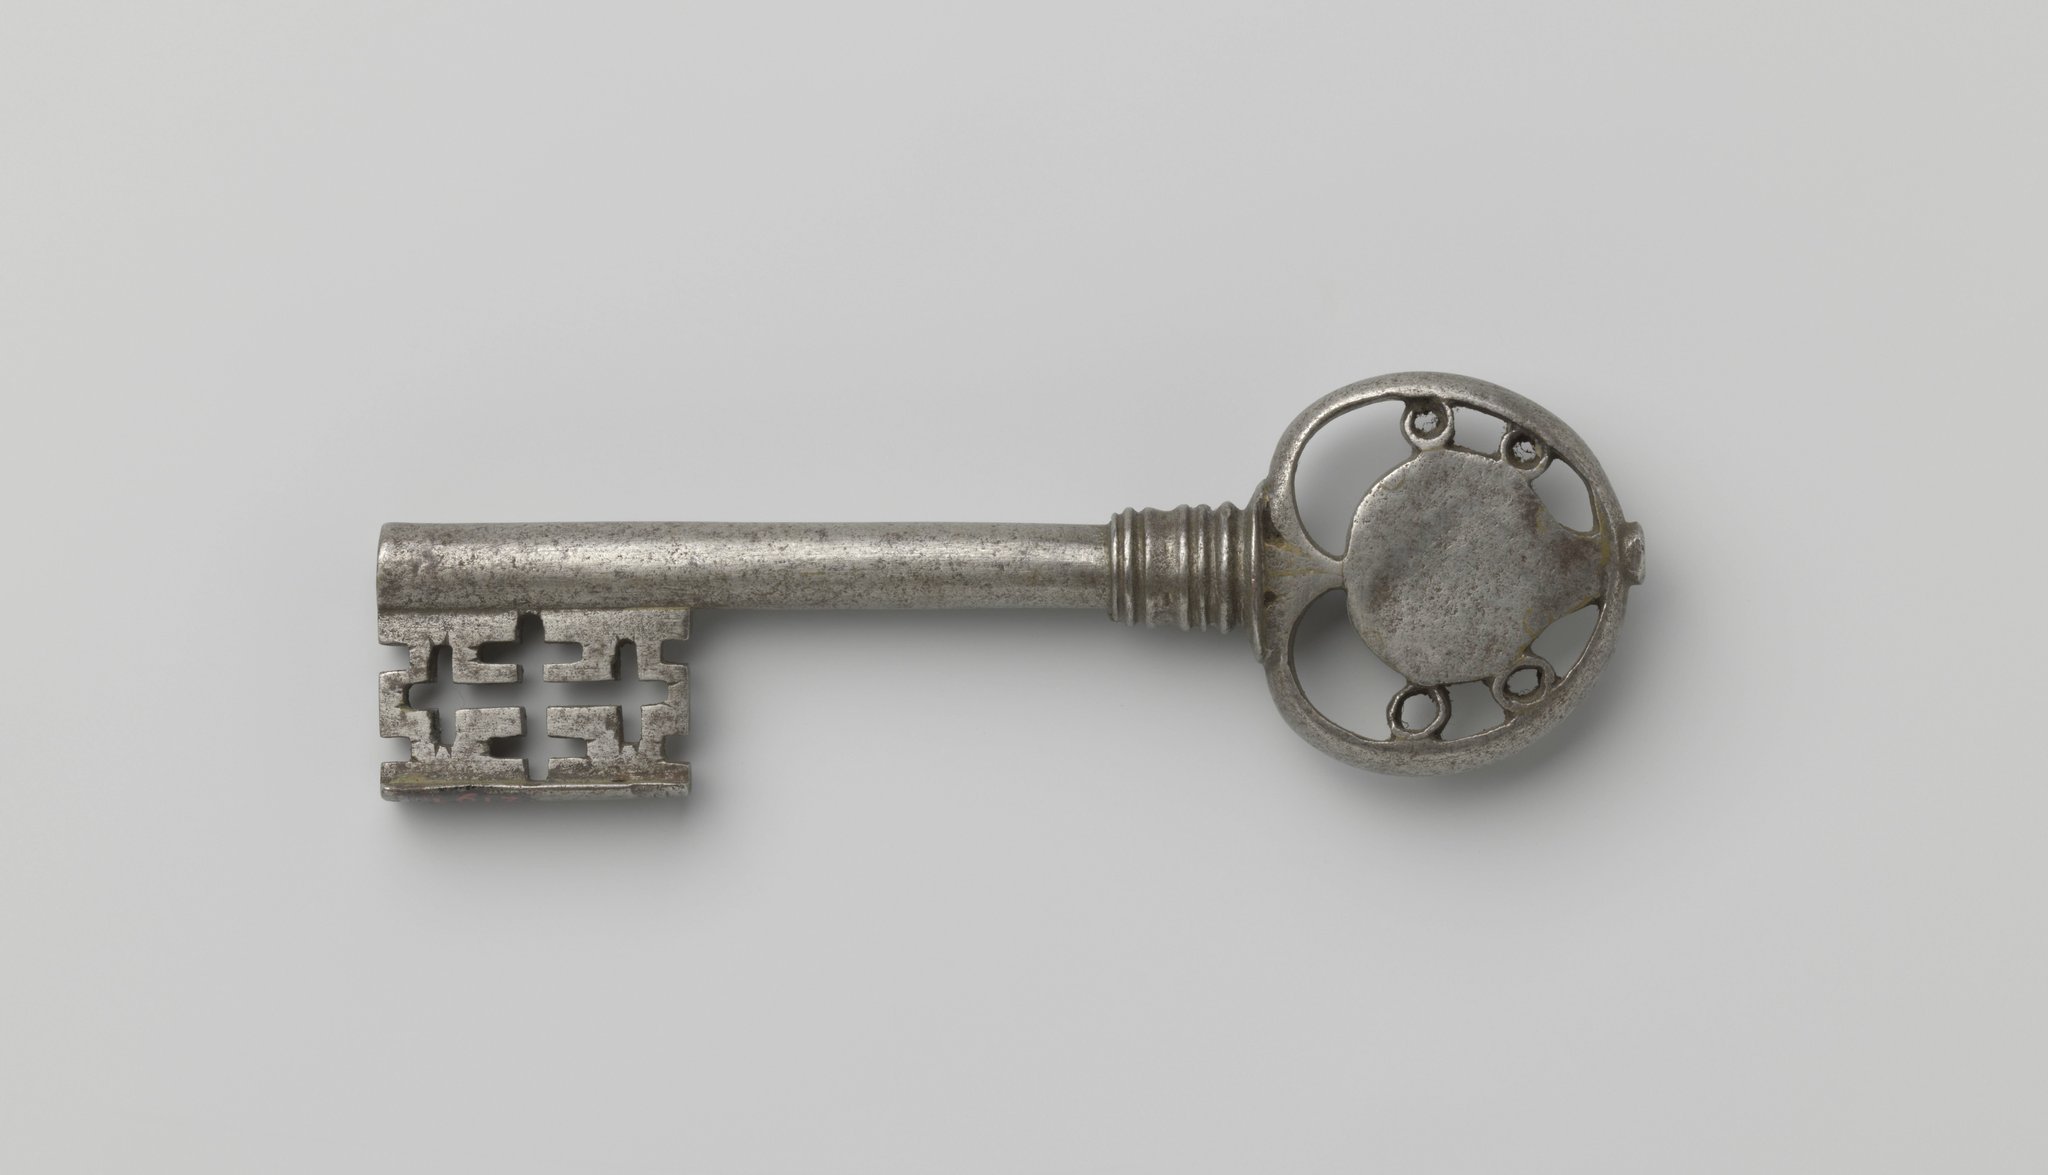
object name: pipe key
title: Pijpsleutel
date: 1500-1600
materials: iron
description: Pijpsleutel met peervormig "doosje" tussen vier oogjes in de ronde greep; zwaar geprofileerd kapiteel en kruisvormige bezetting van de baard.